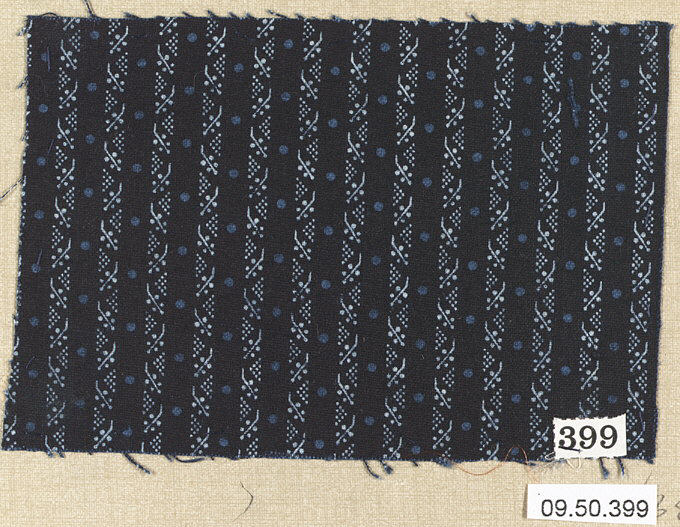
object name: piece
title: Piece (one of 116)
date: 1801-1900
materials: cotton